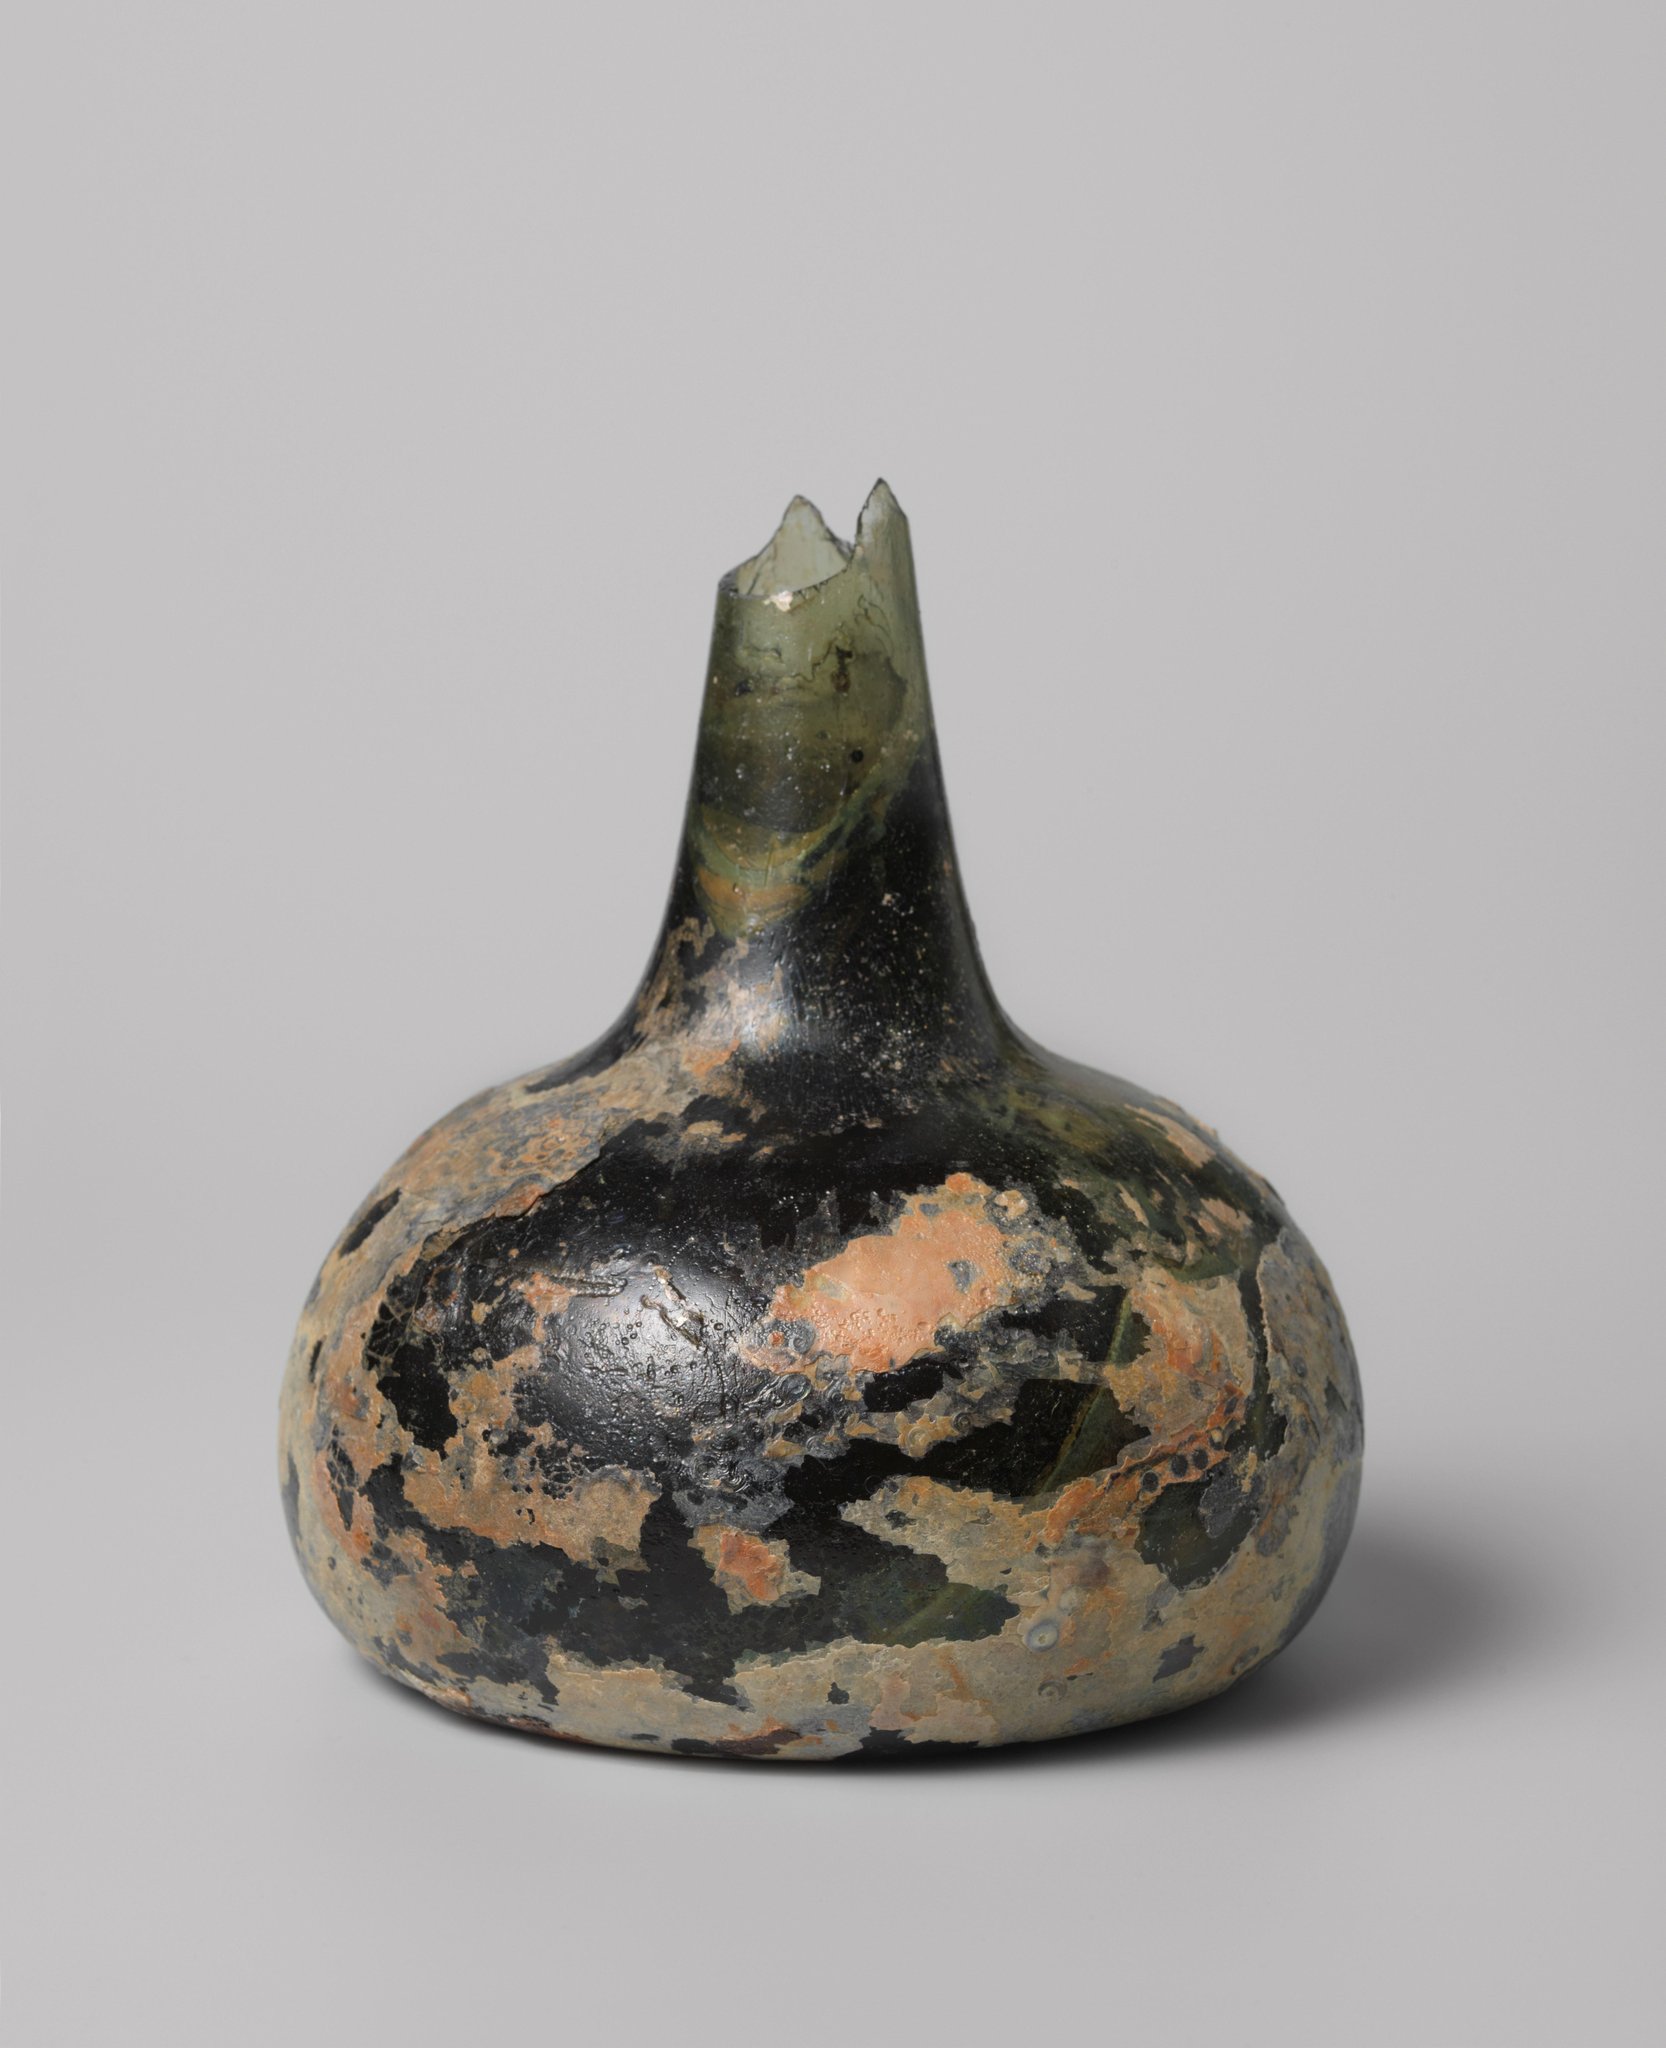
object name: wine bottle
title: Wijnfles uit het wrak van de Oost-Indiëvaarder Hollandia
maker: Anonymous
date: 1700-1743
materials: glass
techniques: green glass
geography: netherlands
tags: verenigde oostindische compagnie, hollandia (schip), annet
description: Wine bottle, continental production, onion-shaped, mouth missing; (1) eroded (16h, belly 15d, base 11d), tcs-kick-up.